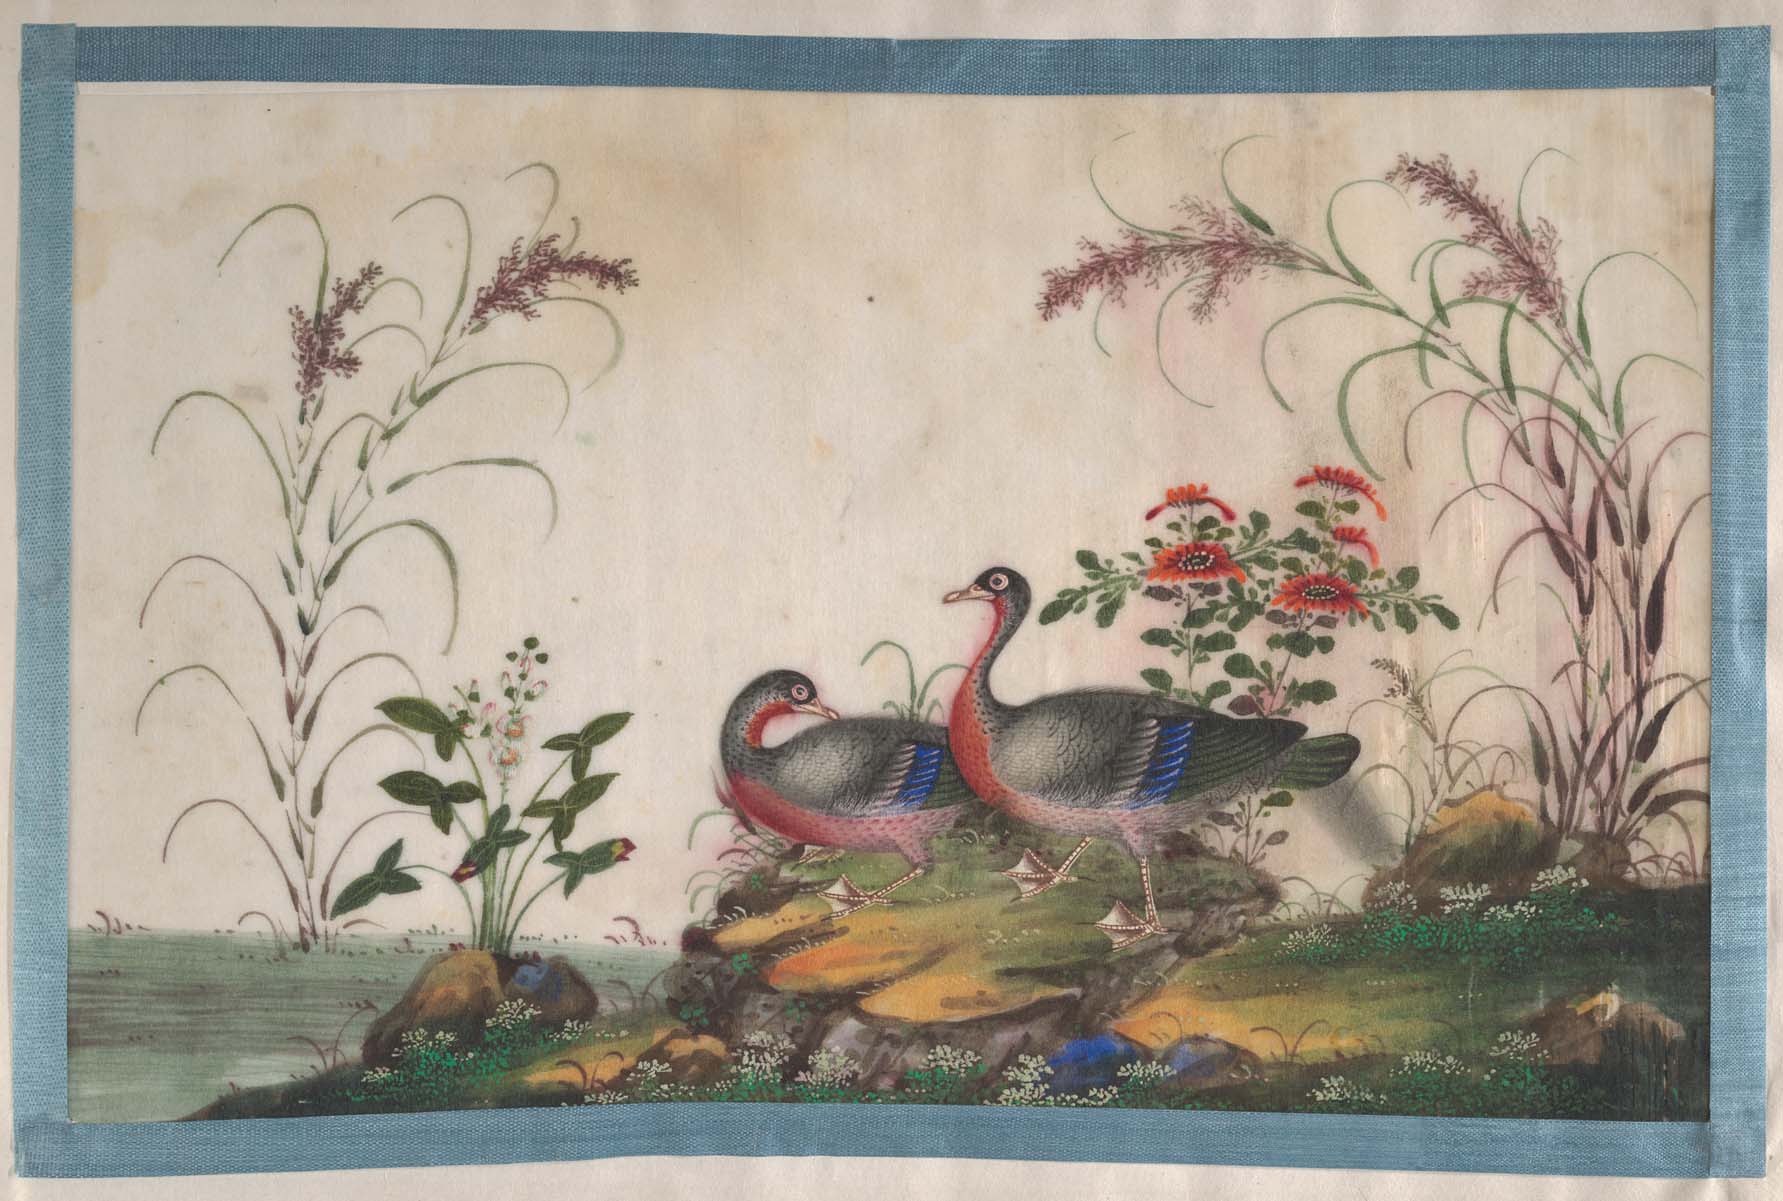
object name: album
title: Album Containing Twelve Paintings of Birds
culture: chinese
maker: unidentified artist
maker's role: artist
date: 1801-1900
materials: paper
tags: birds,flowers